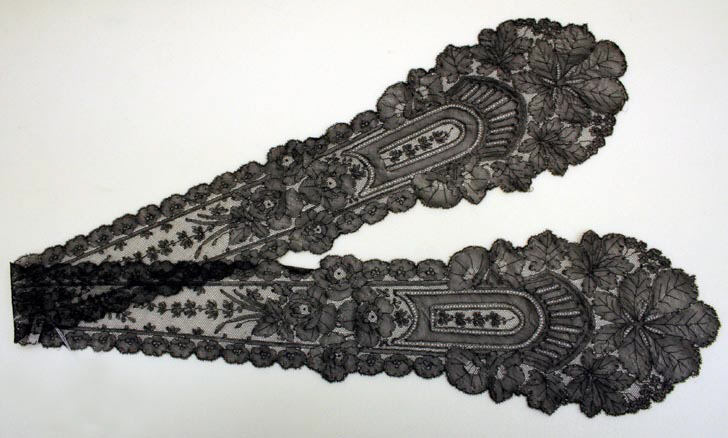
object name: lappet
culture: french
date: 1834-1866